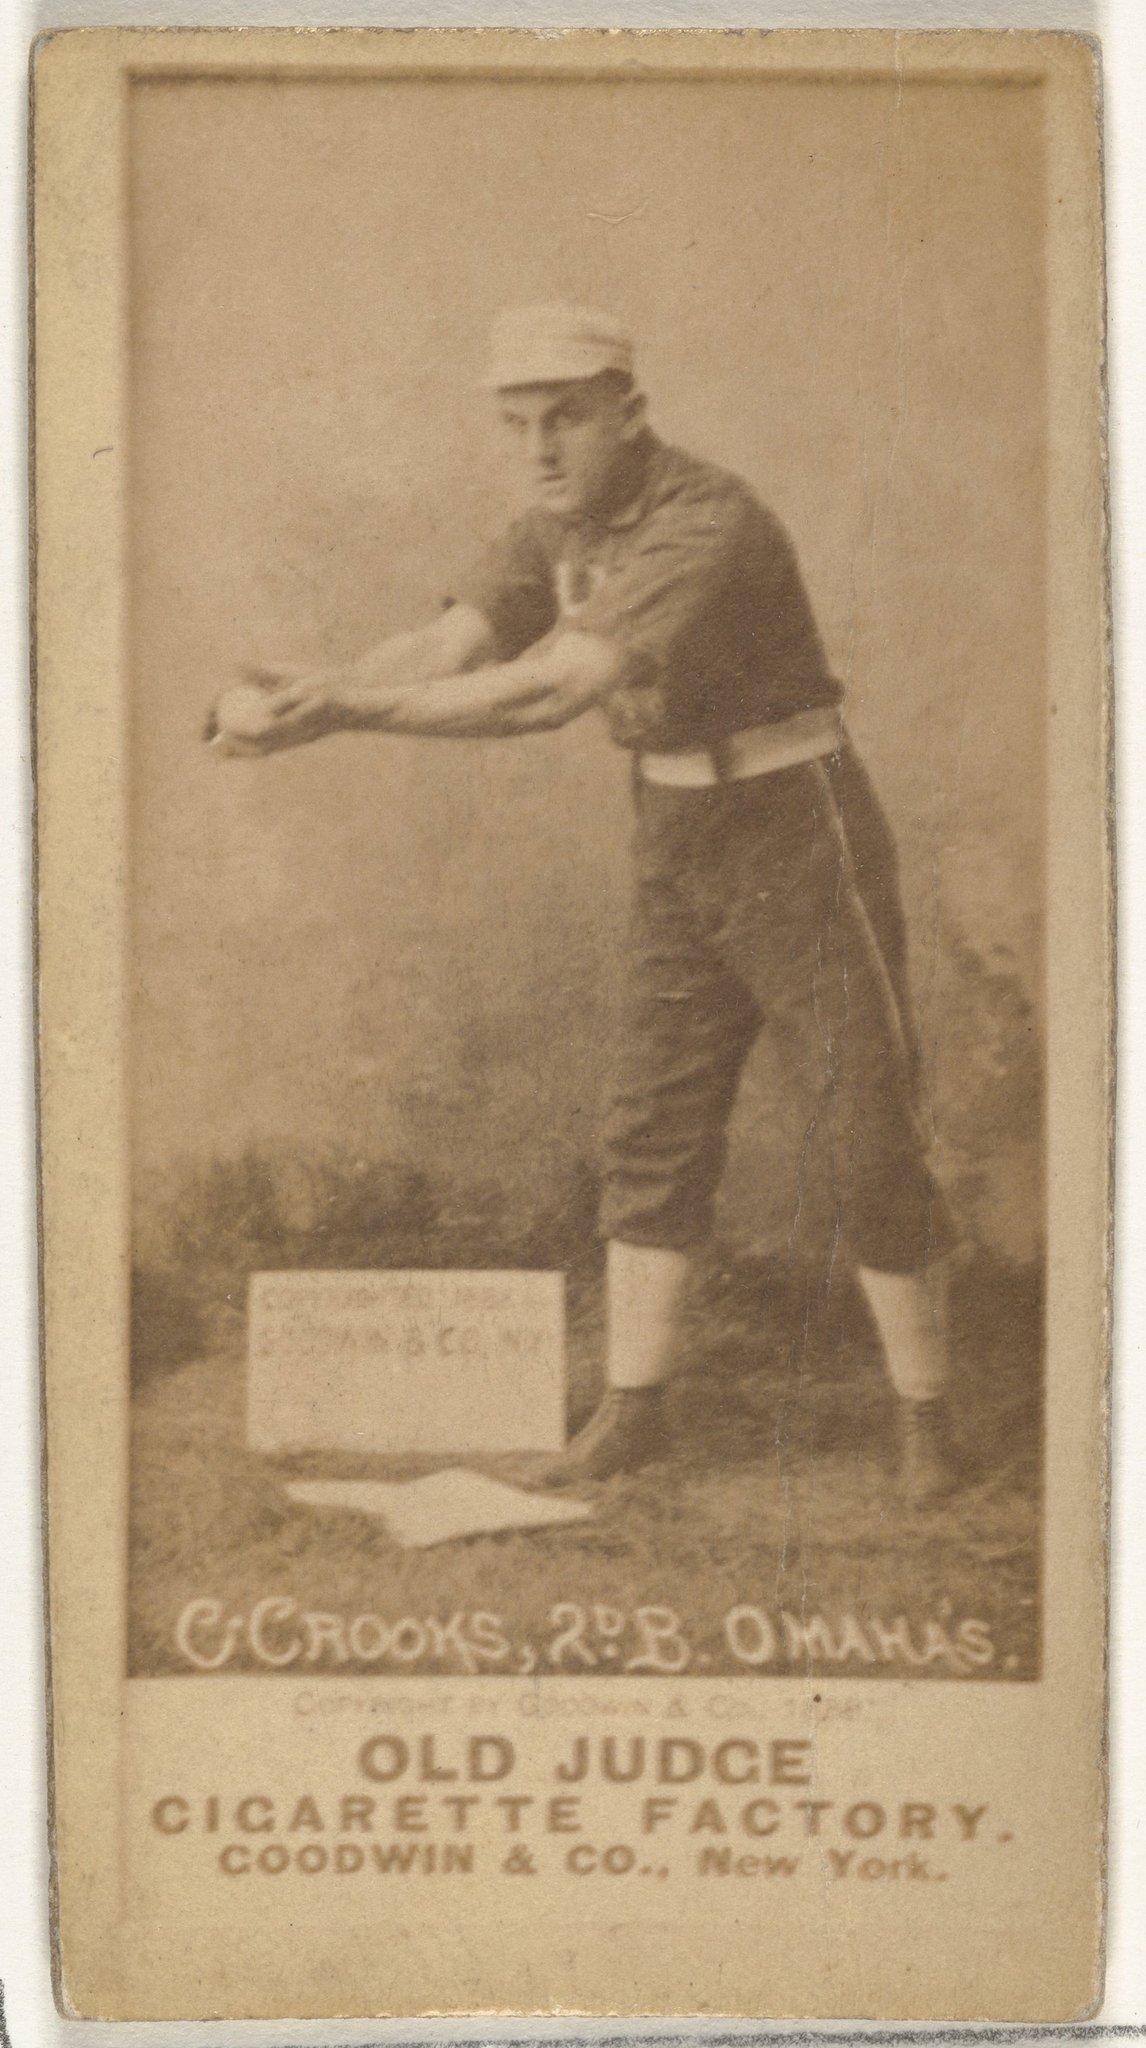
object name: baseball card, photograph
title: John Charles "Jack" Crooks, 2nd Base, Omaha Omahogs/ Lambs, from the Old Judge series (N172) for Old Judge Cigarettes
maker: goodwin & company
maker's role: publisher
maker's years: 1850-1950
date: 1888-1889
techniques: albumen silver print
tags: men,portraits,baseball,athletes